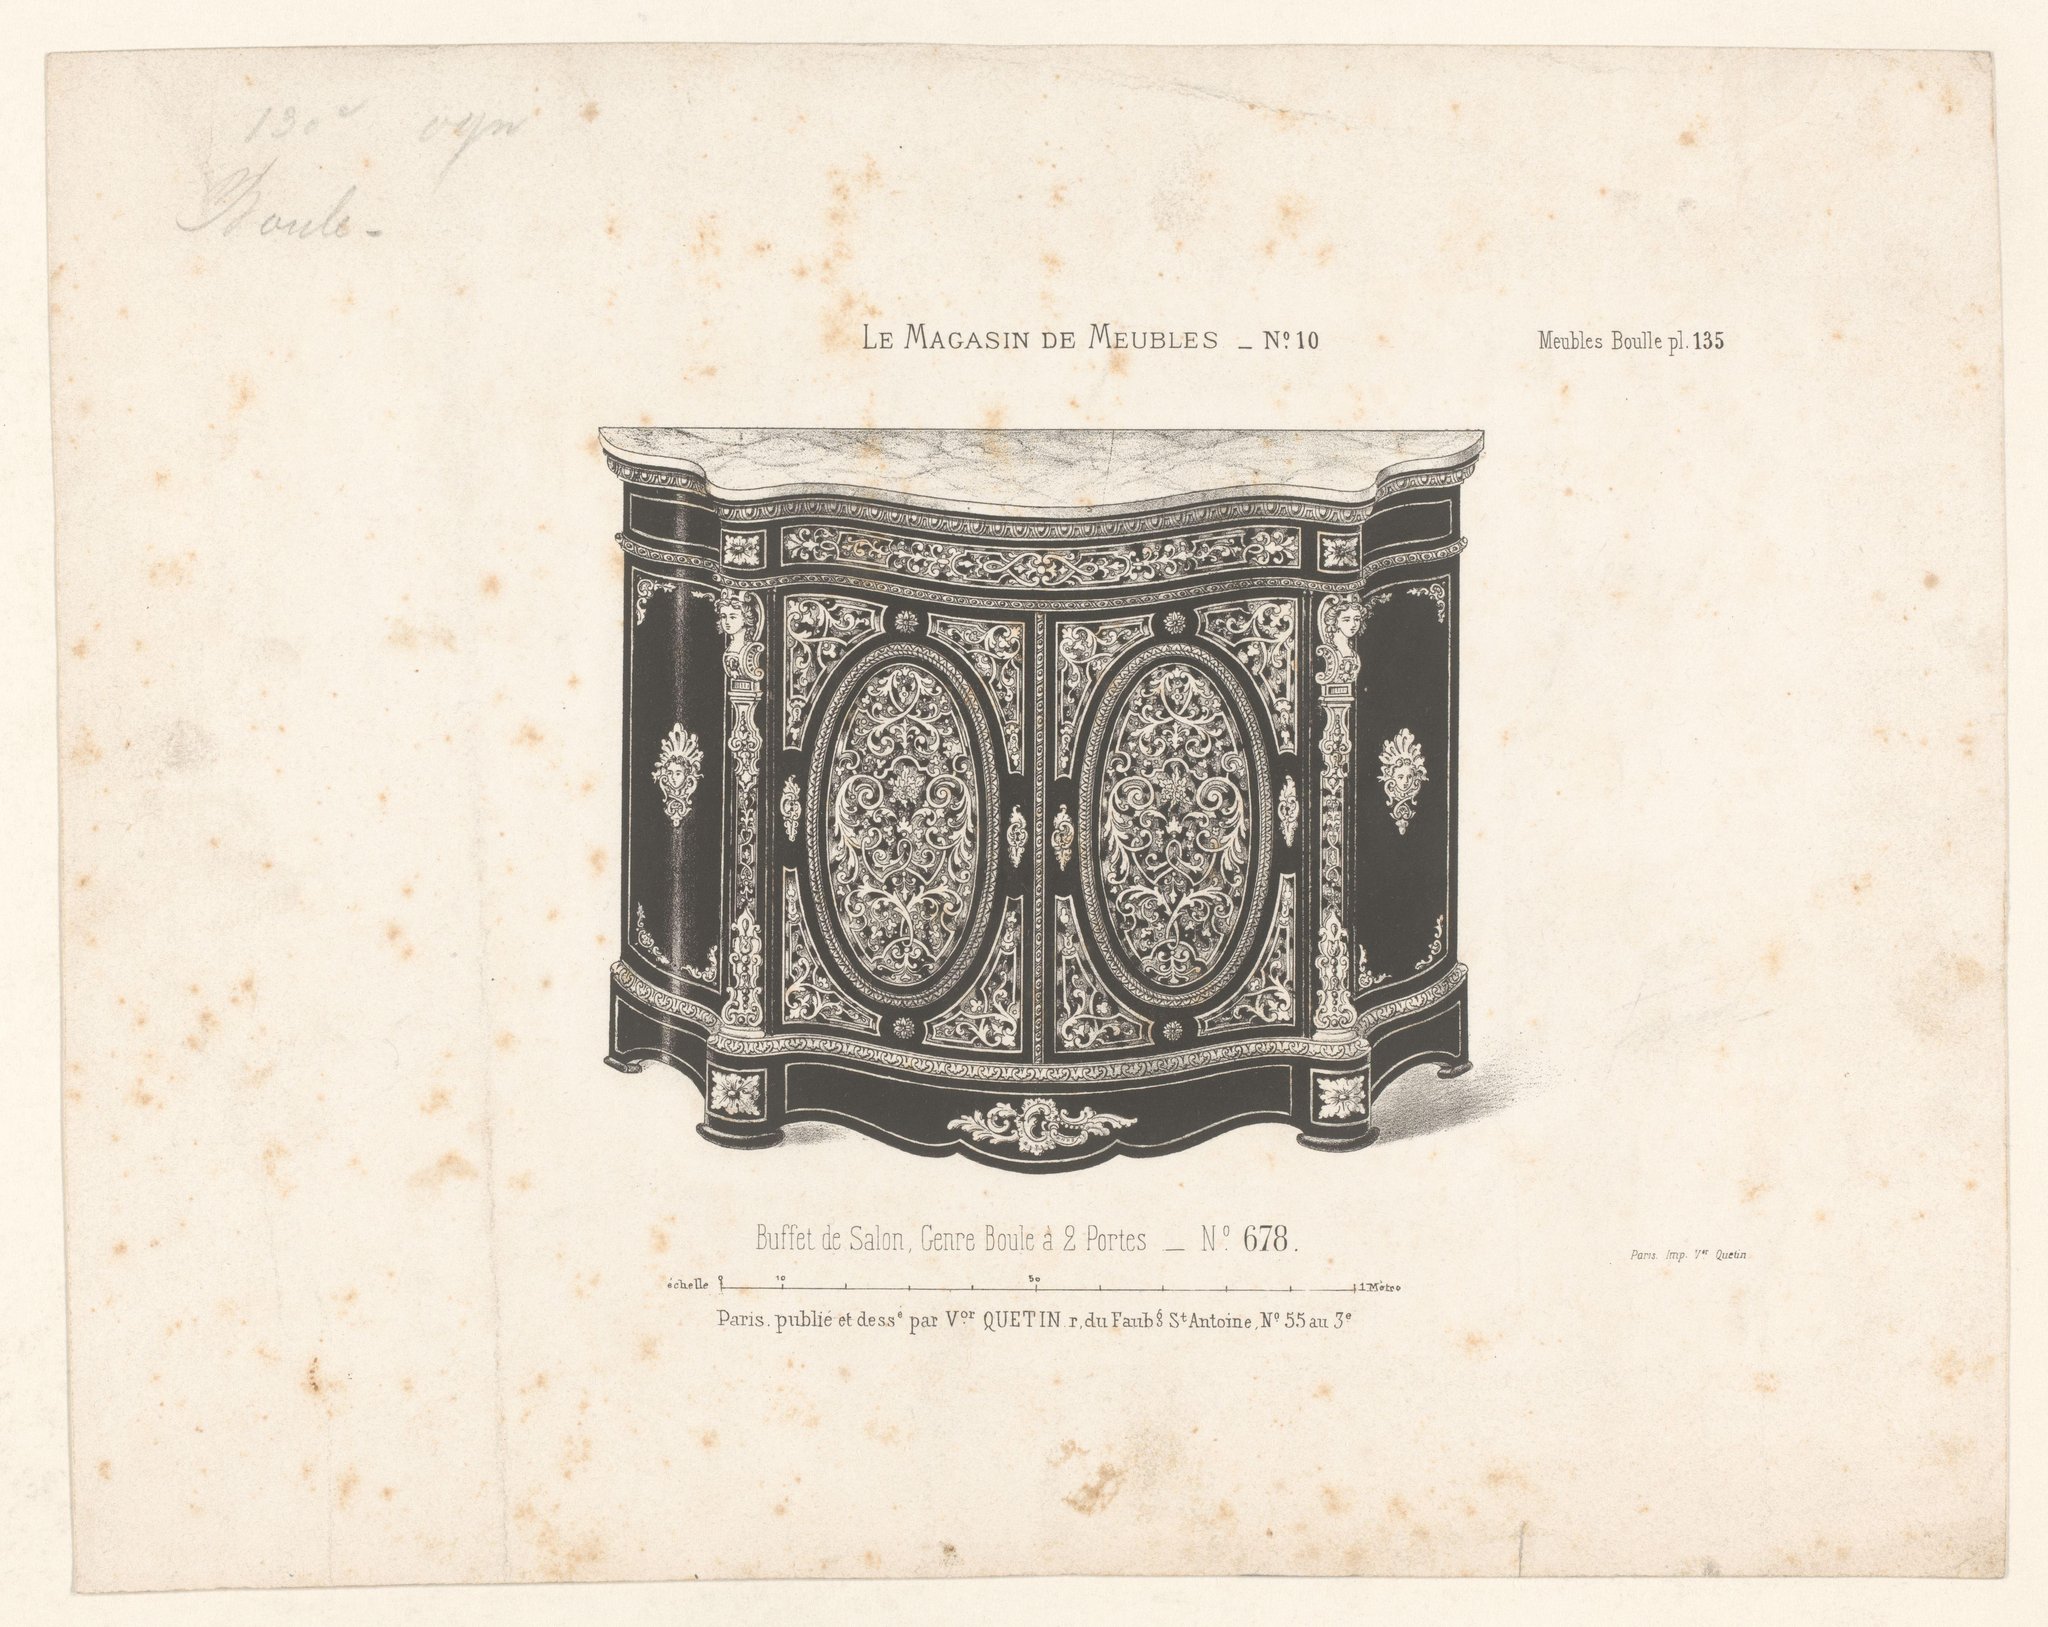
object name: print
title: Le Magasin de Meubles No 10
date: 1832-1877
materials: paper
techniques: lithograph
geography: paris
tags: furniture for storage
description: Een lage kast. Rechts boven vermeld Meubles Boulle pl. 135.